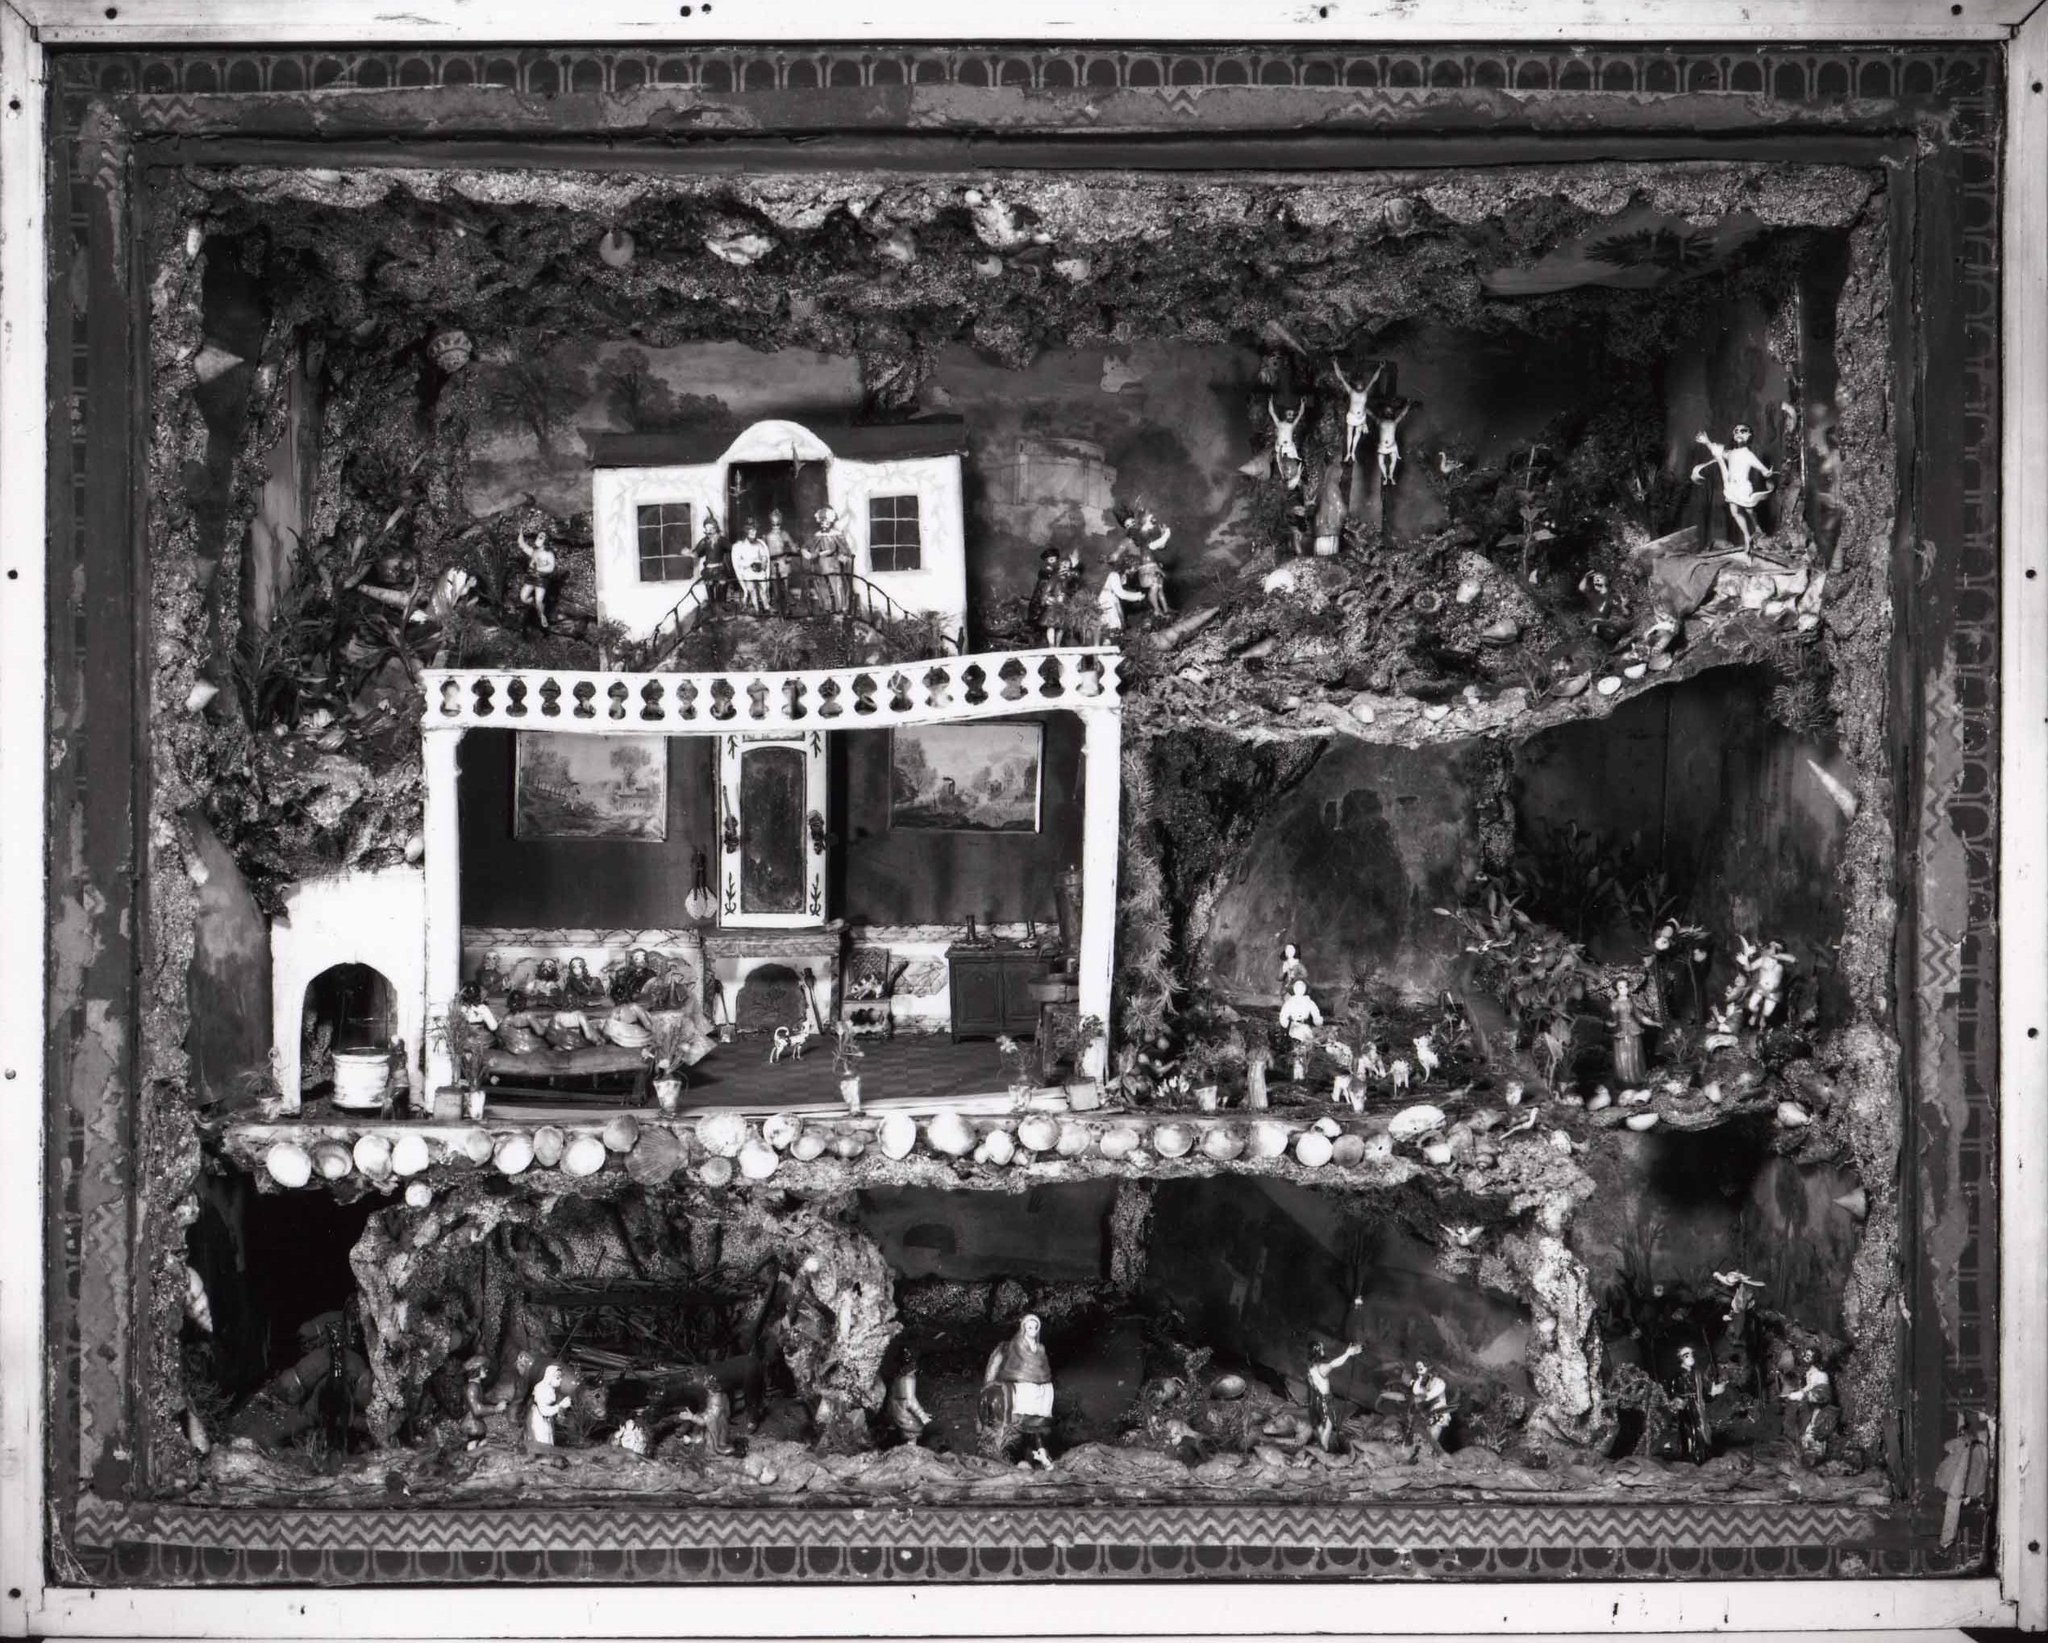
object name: figurine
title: The Life of Christ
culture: french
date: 1701-1800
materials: cardboard, cork, glass, metal, paint, paper, shell, wood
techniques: lampwork, painting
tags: christ